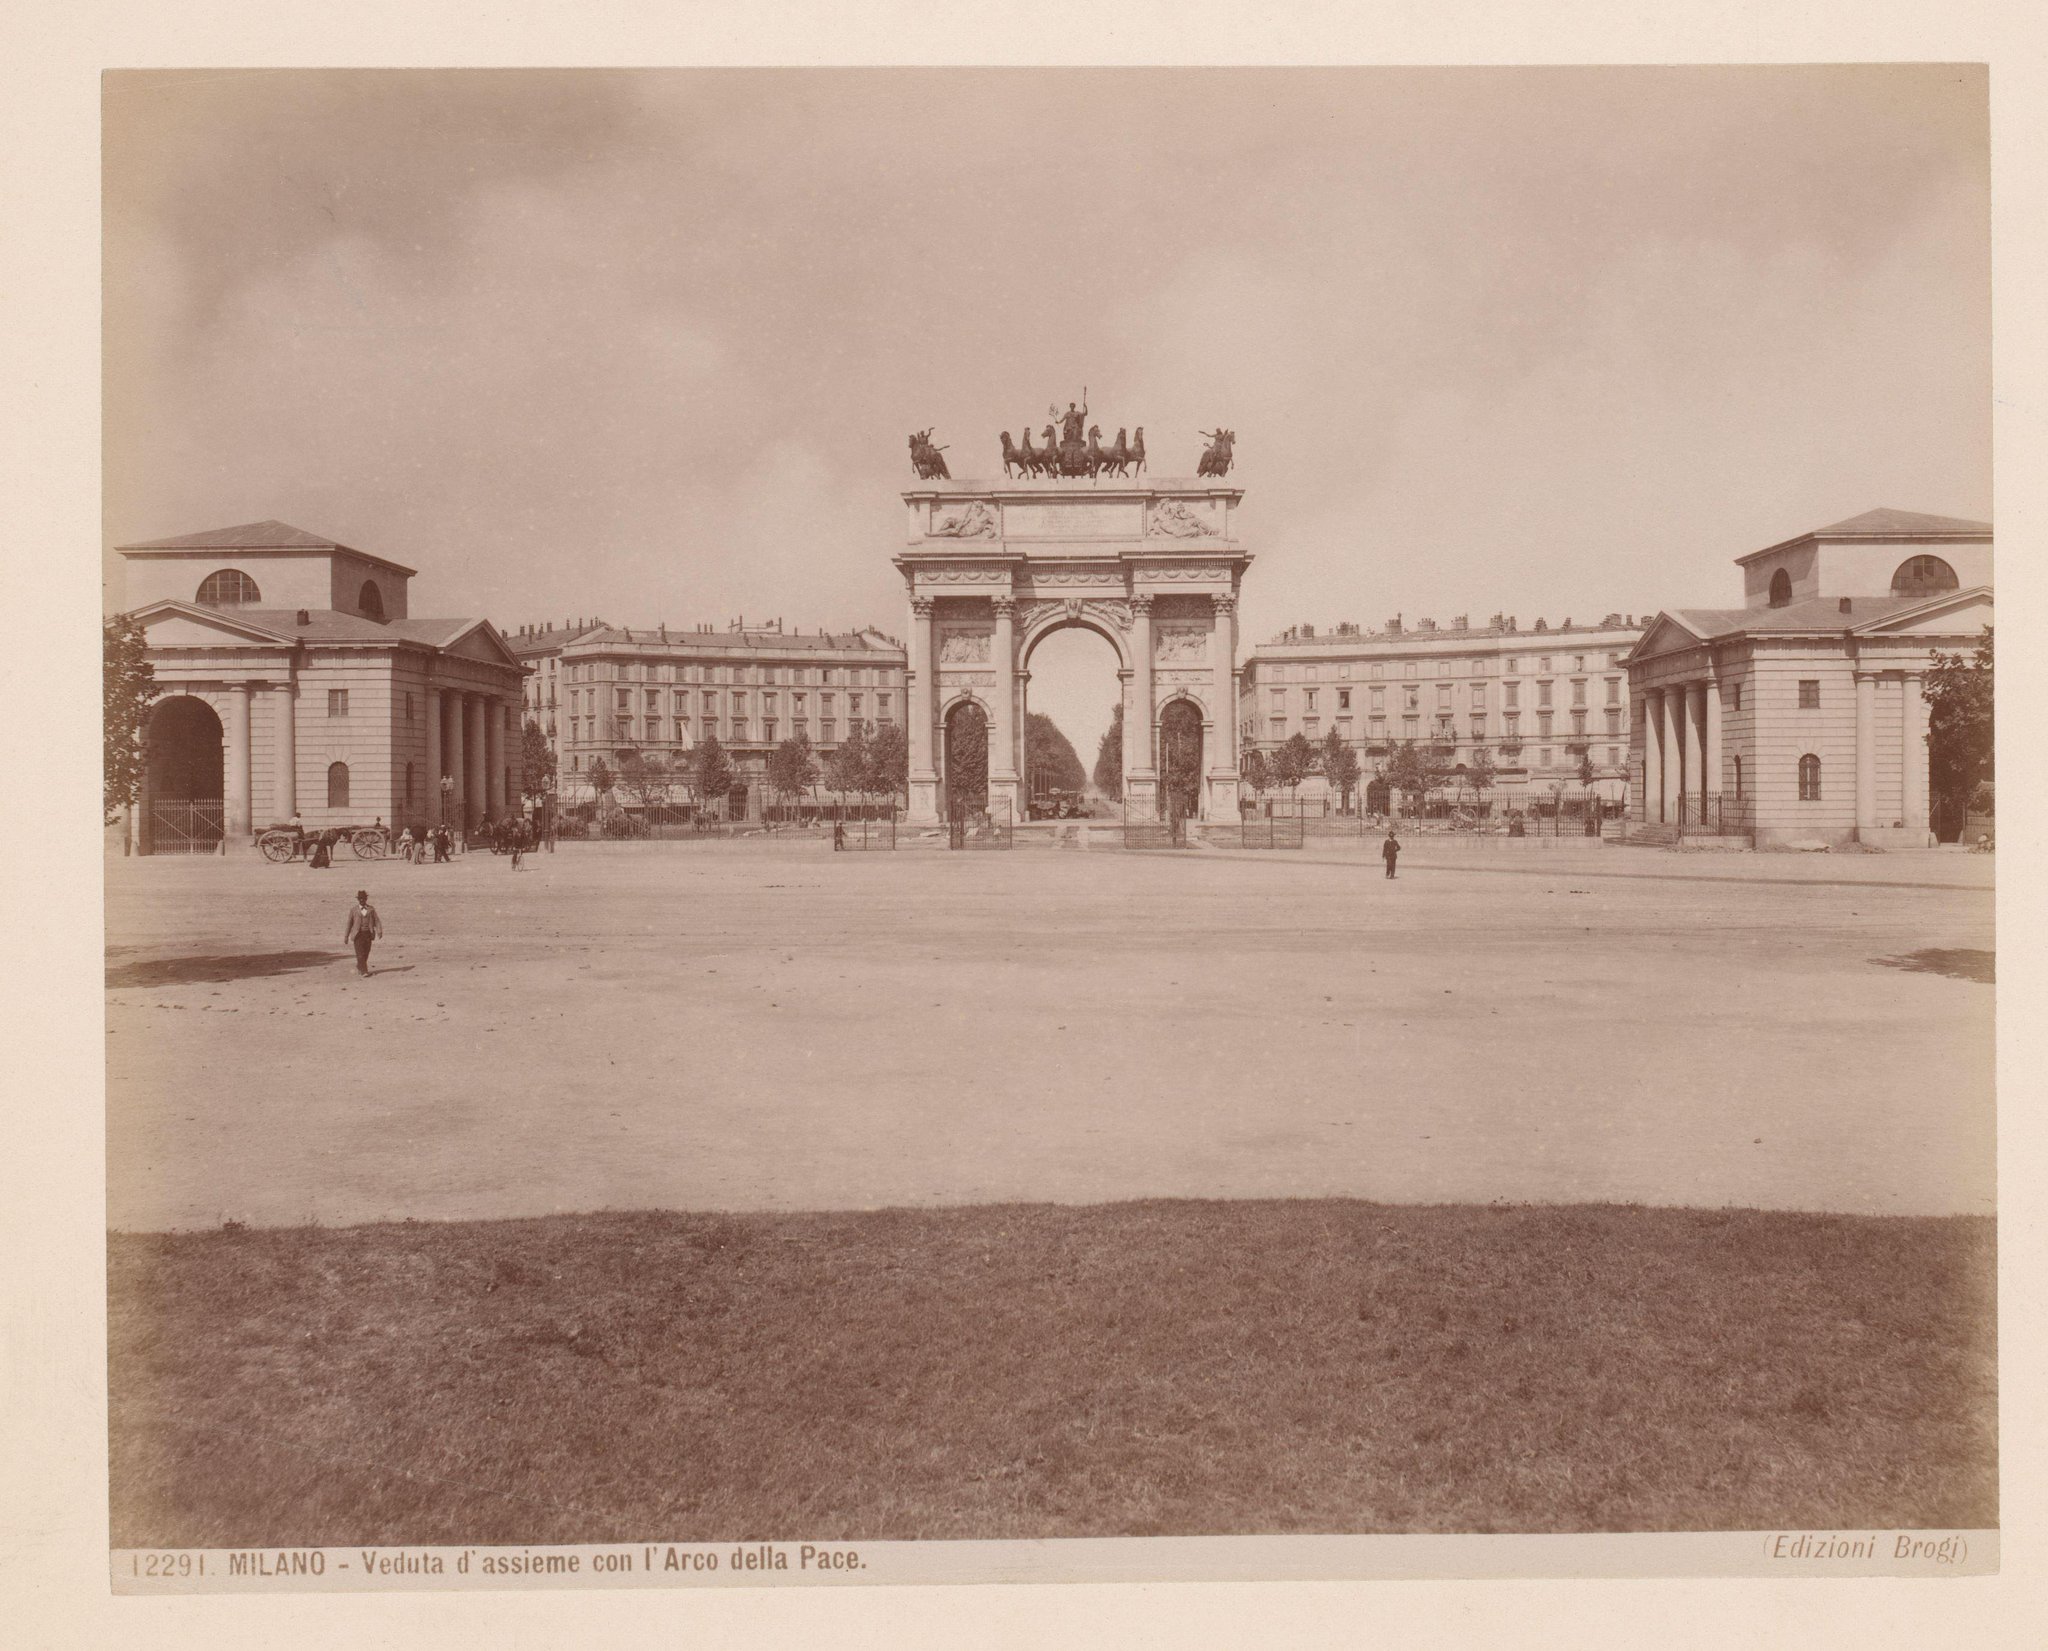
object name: photograph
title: Veduta d'assieme con Arco della Pace, Milaan, Italië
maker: giacomo brogi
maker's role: fotograaf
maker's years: 1822-1881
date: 1860-1890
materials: cardboard, paper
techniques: albumen print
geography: florence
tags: milaan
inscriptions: caption: ‘(EDIZIONI BROGI)’, caption: ‘12291. MILANO - Veduta d'assieme con l 'Arco della Pace.’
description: Veduta d'assieme con Arco della Pace, Milaan, Italië.